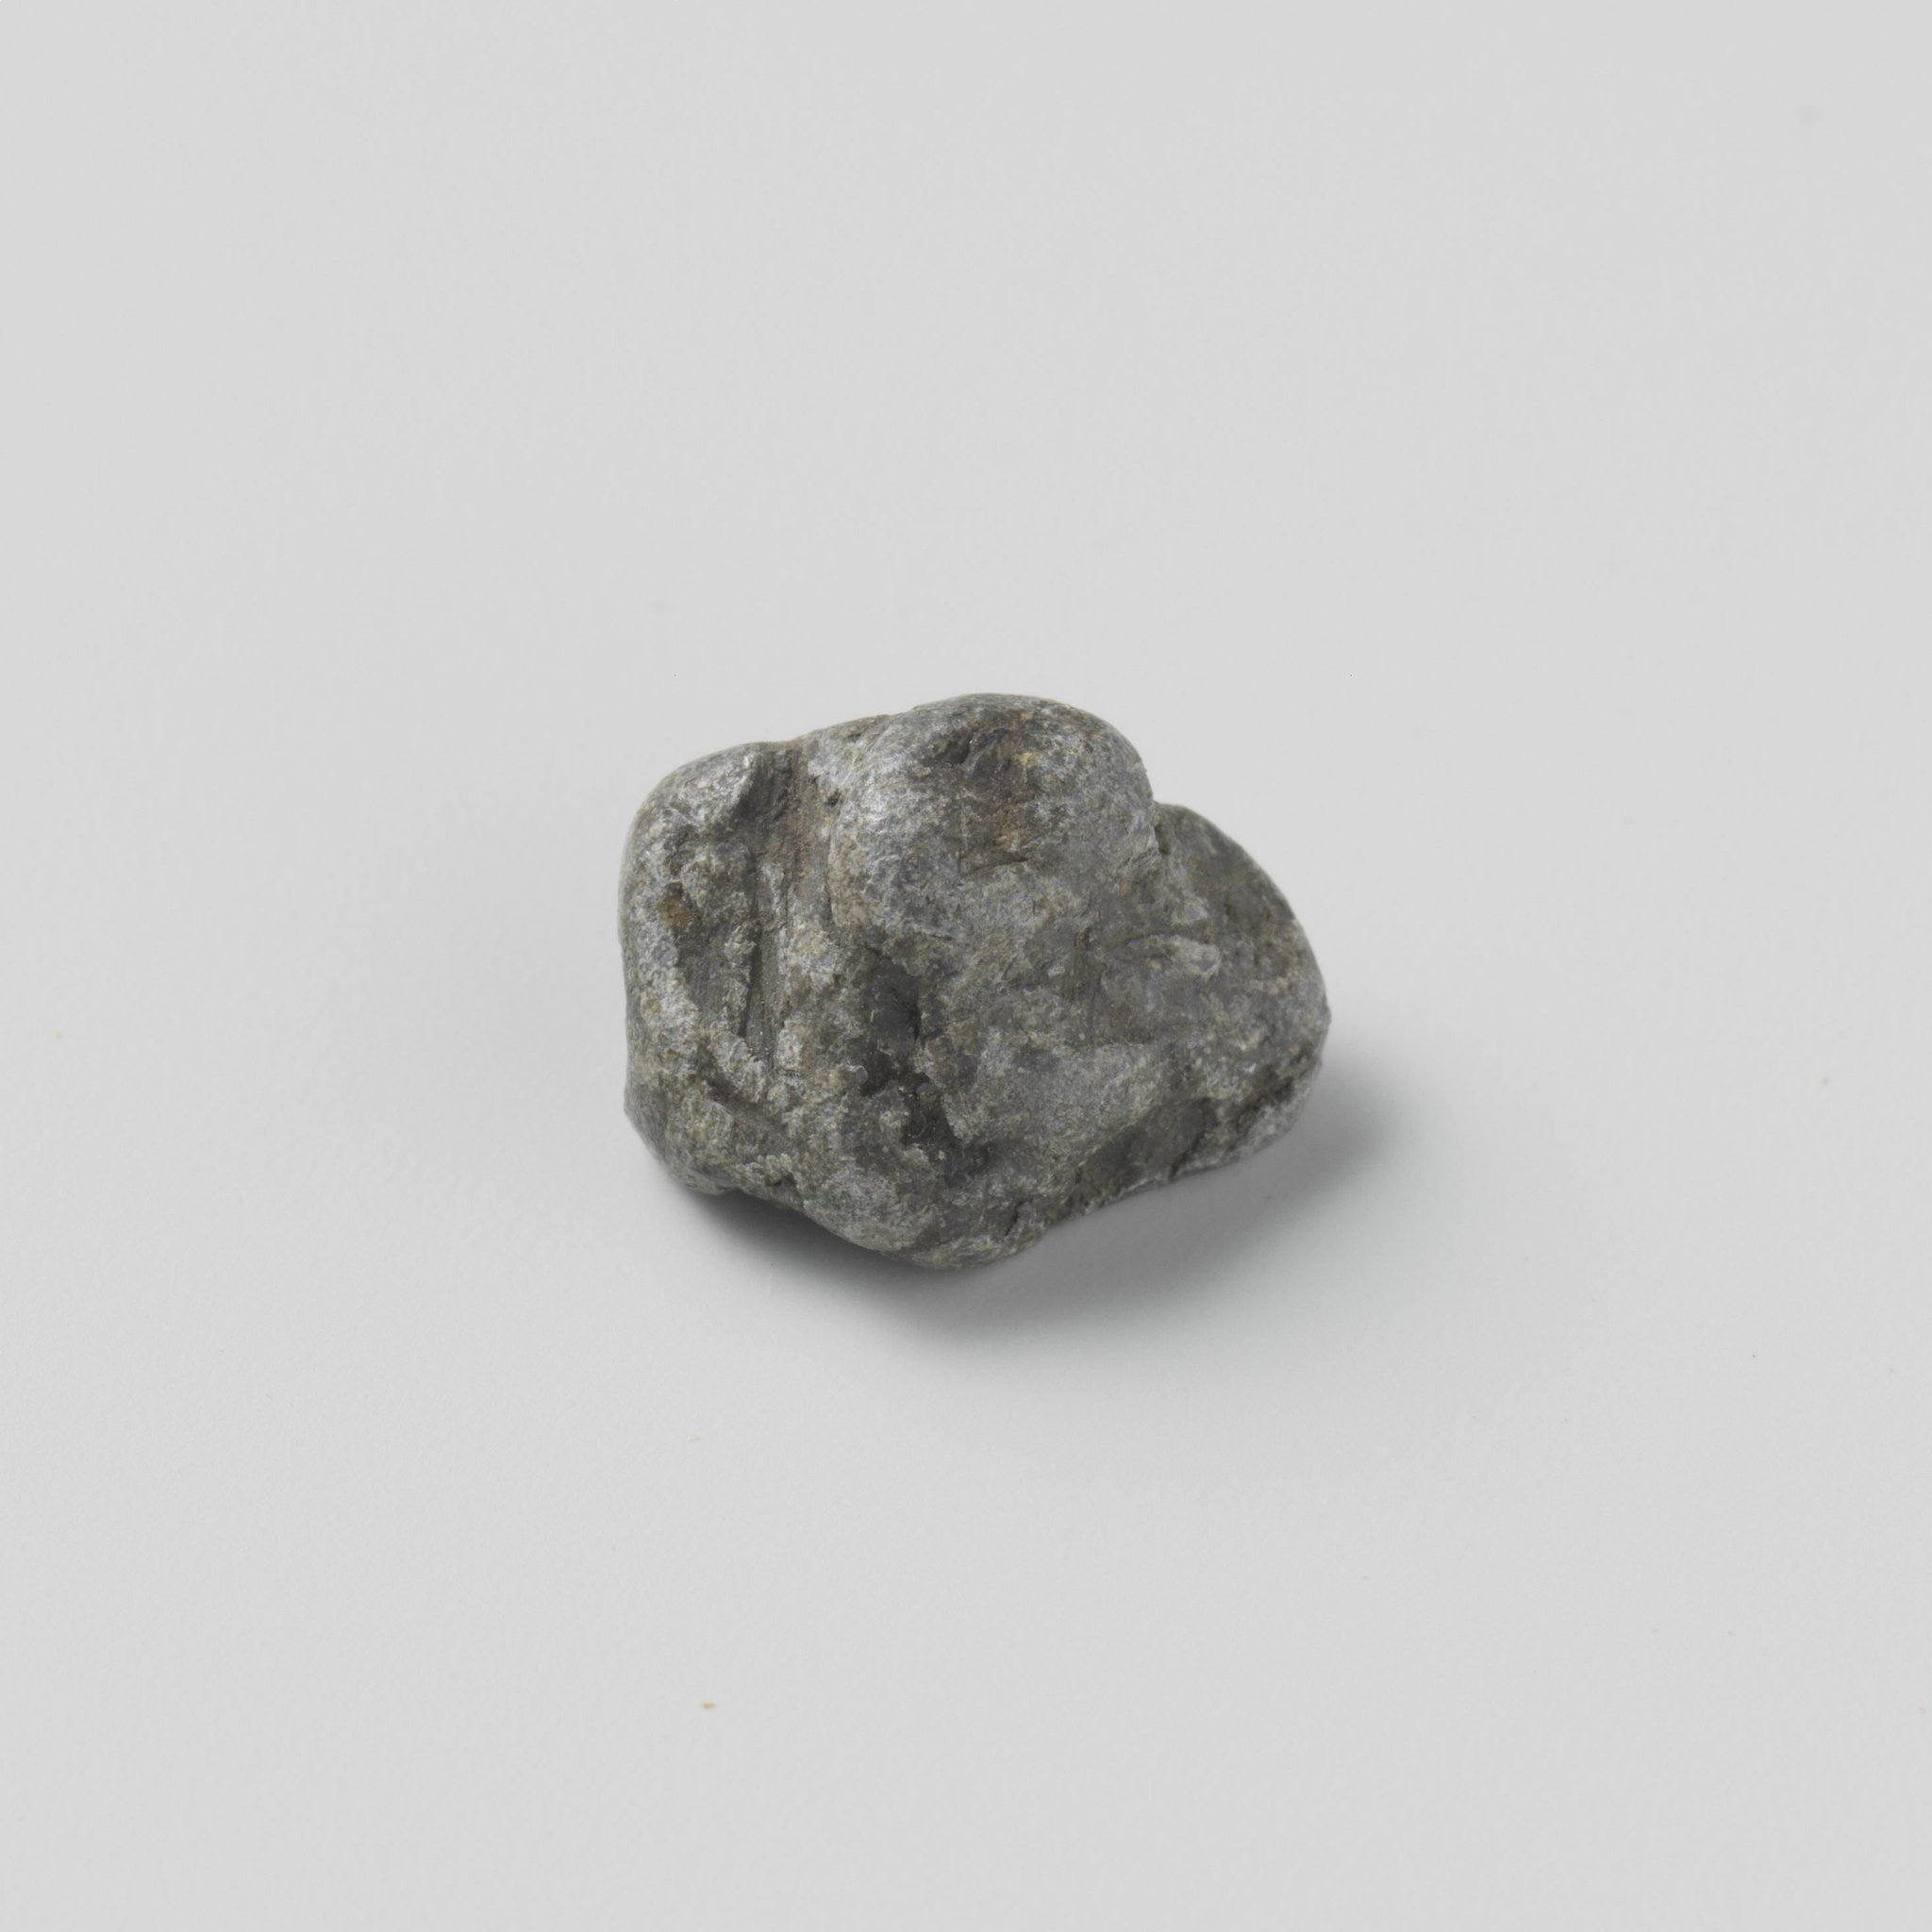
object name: bullet ammunition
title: Pistol Bullet that Struck Henry Casimir I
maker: Anonymous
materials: lead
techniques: casting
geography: netherlands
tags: arnhem, hendrik casimir i graaf van nassau-dietz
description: Hendrik Casimir I (1612-1640), stadhouder van Friesland, werd tijdens de Slag bij Hulst dodelijk in zijn onderrug getroffen. Deze kogel zou volgens overlevering zijn verwijderd uit de wond in zjin heup, samen met enkele stukjes bot. Kogel en stukjes bot werden hierna in de stadhouderlijke verzameling bewaard.